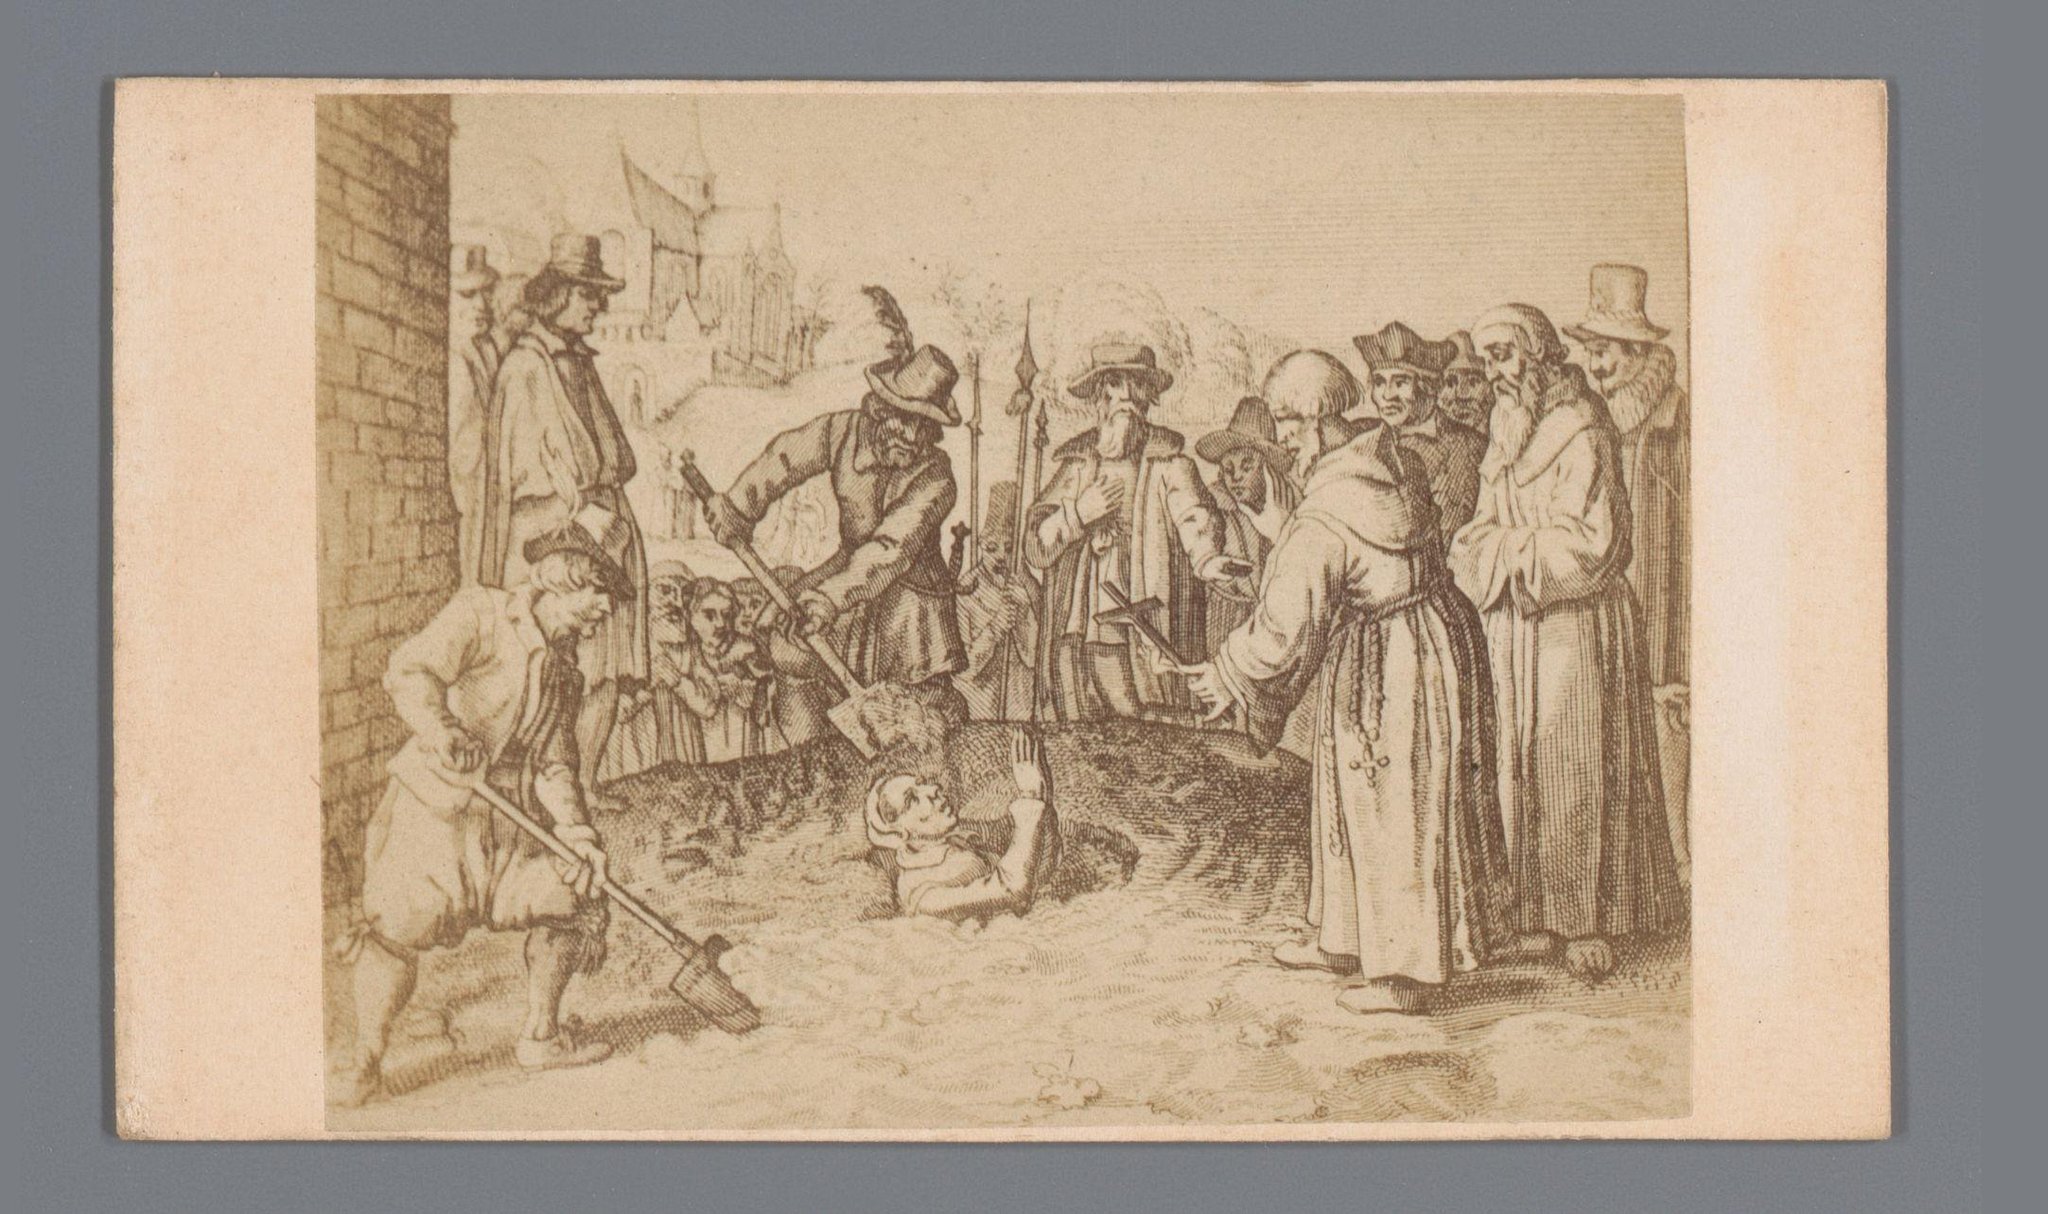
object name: carte de visite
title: De Spaansche Inquizitie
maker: Anonymous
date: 1855-1885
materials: cardboard, paper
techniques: albumen print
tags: buried alive (violent death)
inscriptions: number: ‘No. 7.’, inscription: ‘Anneke van den Hove, te Brussel in 1597 levend begraven.’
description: In 1597 werd de doopsgezinde Anneke van den Hove levend begraven in Brussel. Naar een prent van een anonieme maker. Vgl. RP-P-OB-78.998.